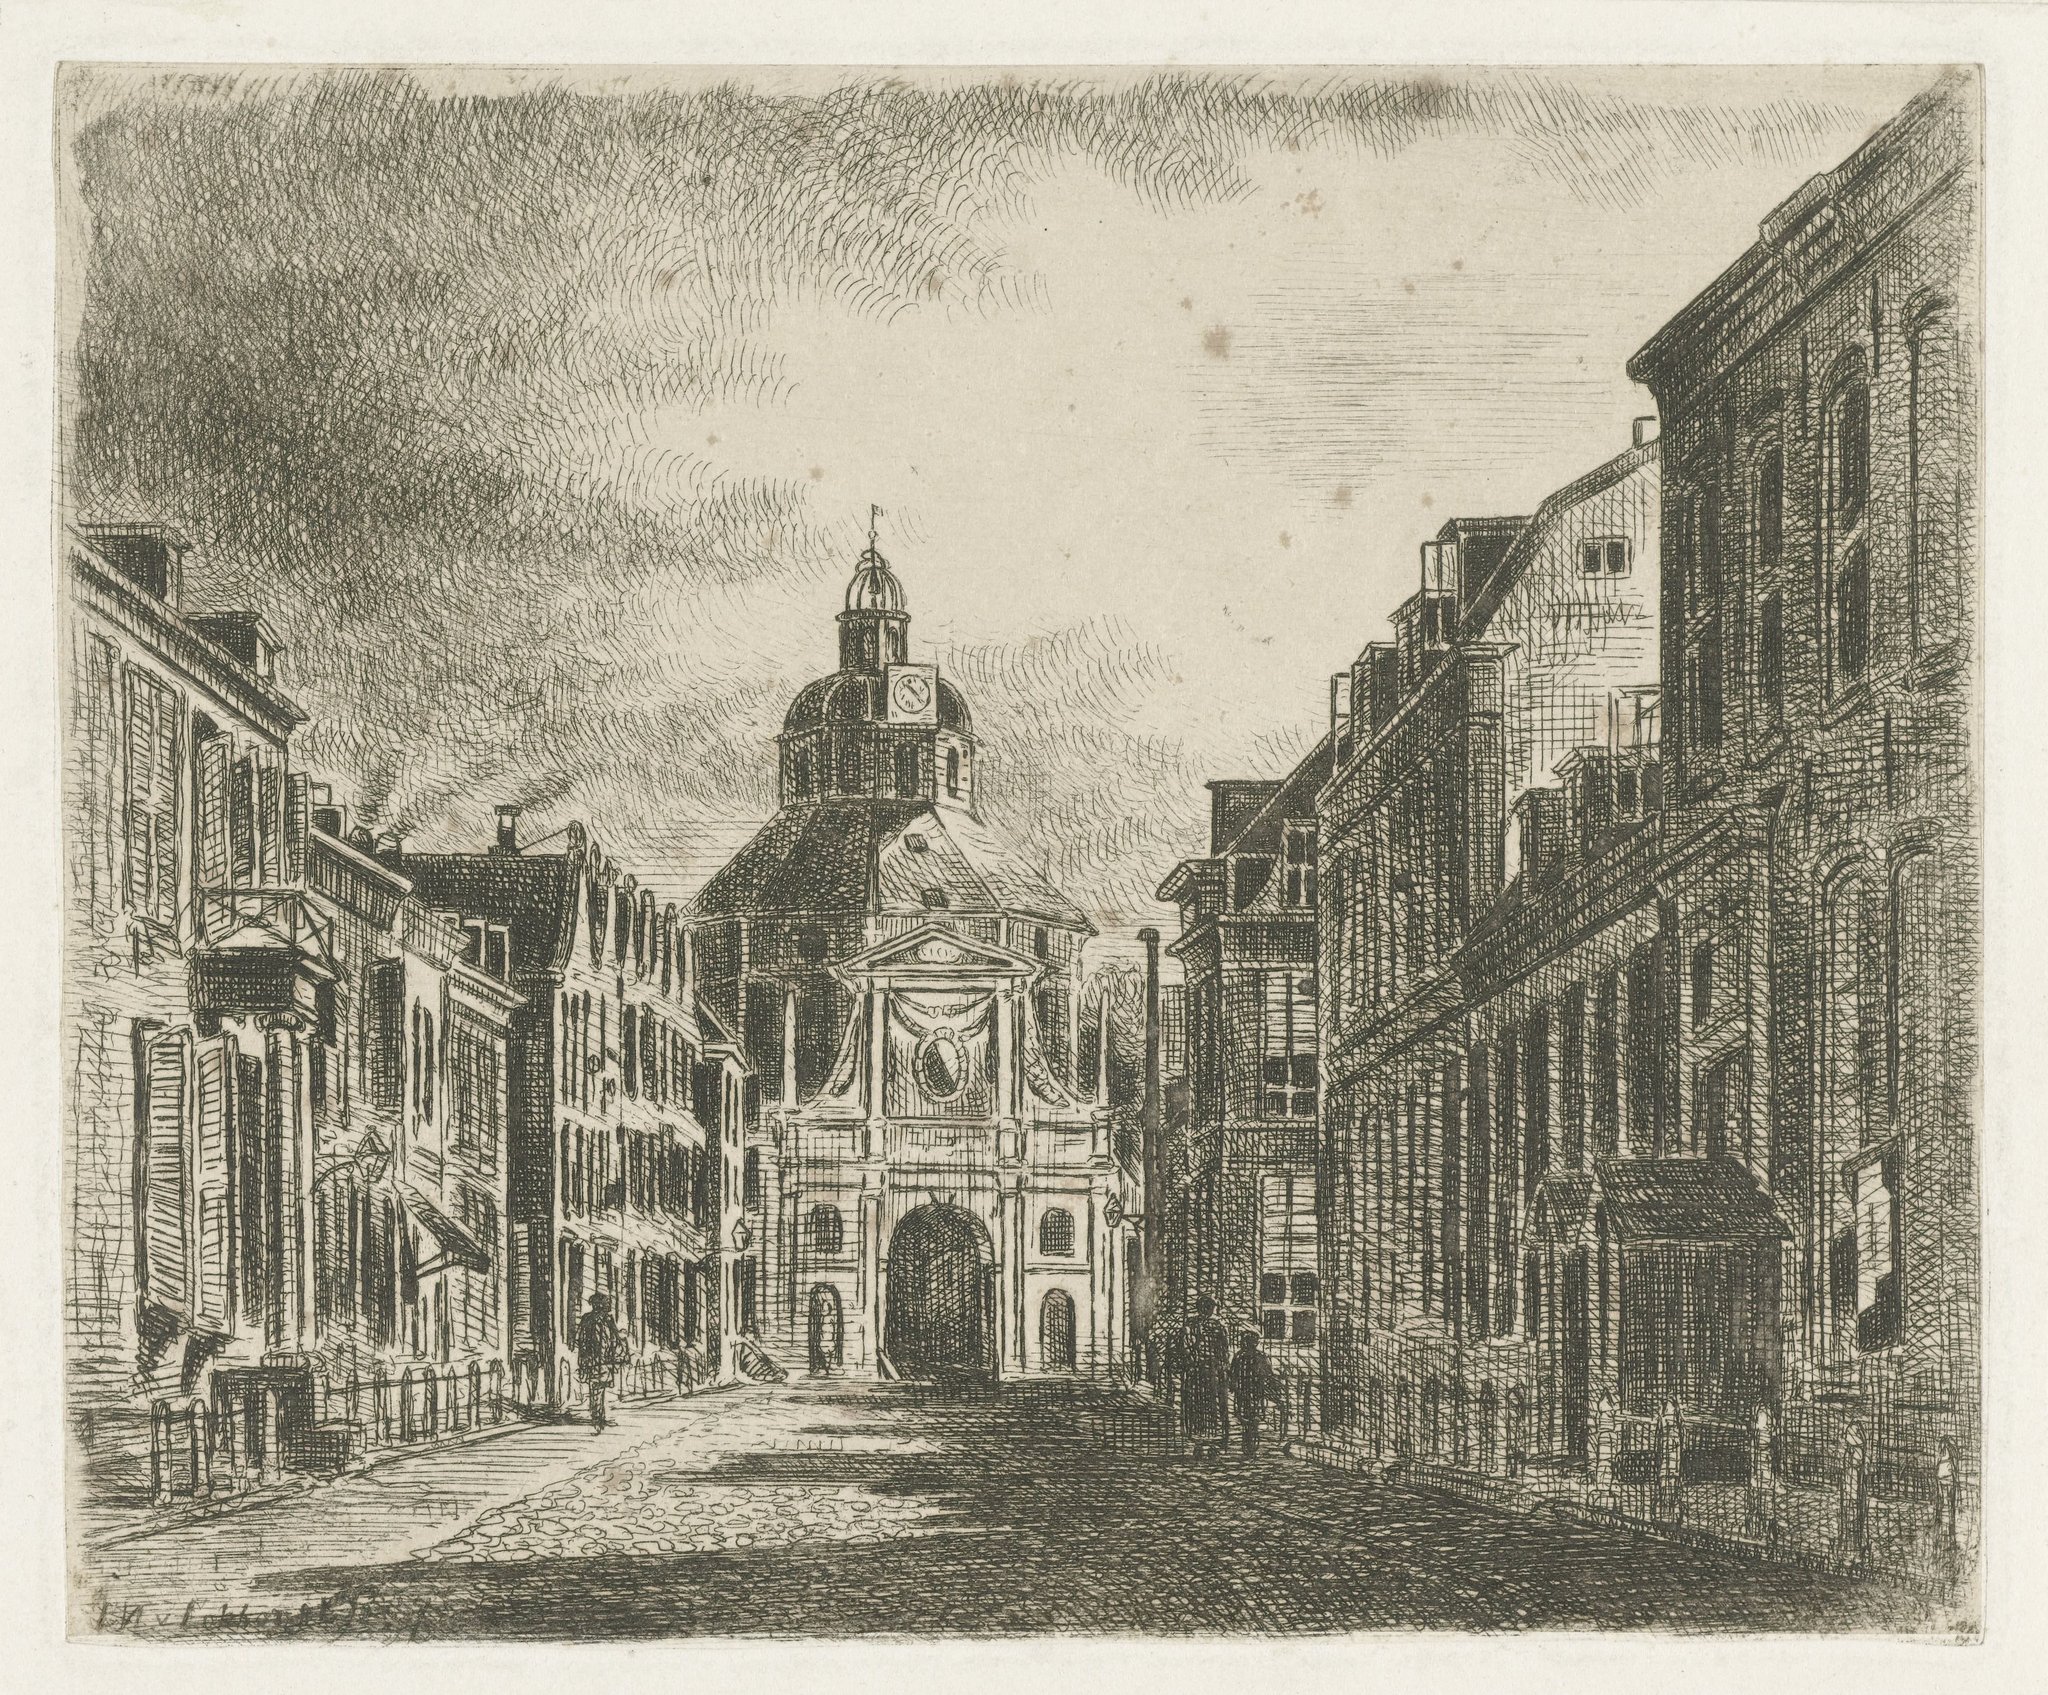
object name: print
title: Gezicht op de Wittevrouwenpoort te Utrecht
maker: jan van lokhorst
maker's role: draughtsman, print maker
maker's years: 1837-1894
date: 1847-1874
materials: paper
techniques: etching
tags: street, city-gate (+ city(-scape) with figures, staffage)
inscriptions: collector's mark: Lugt 2228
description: De Wittevrouwenpoort te Utrecht, gezien vanuit de stad. Links en rechts lopen enkele passanten op de stoep.